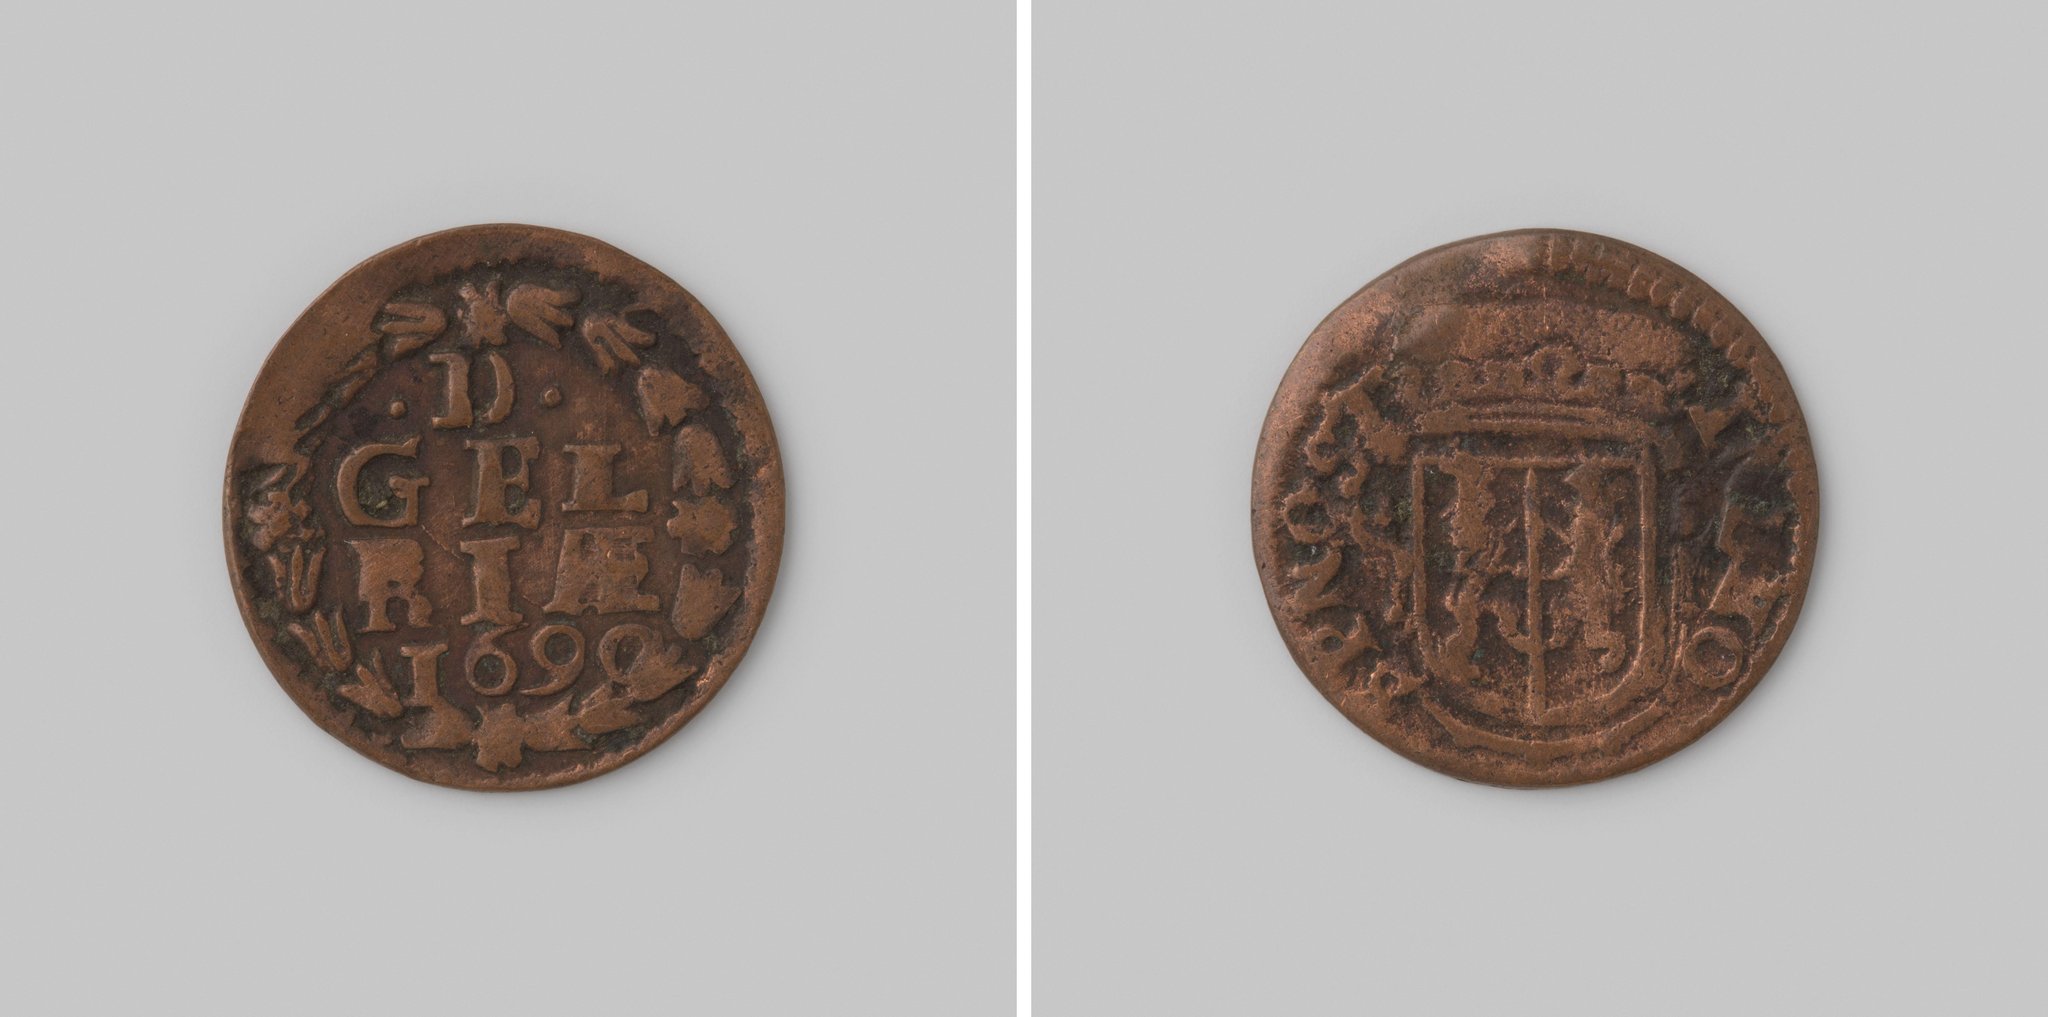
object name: coin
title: Gelderse duit, 1690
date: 1690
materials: copper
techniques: striking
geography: harderwijk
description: Koperen munt. Voorzijde: binnen lauwerkrans in drie regels D/GEL/RIAE, daaronder jaartal. Keerzijde: gekroond Gelders wapenschild.